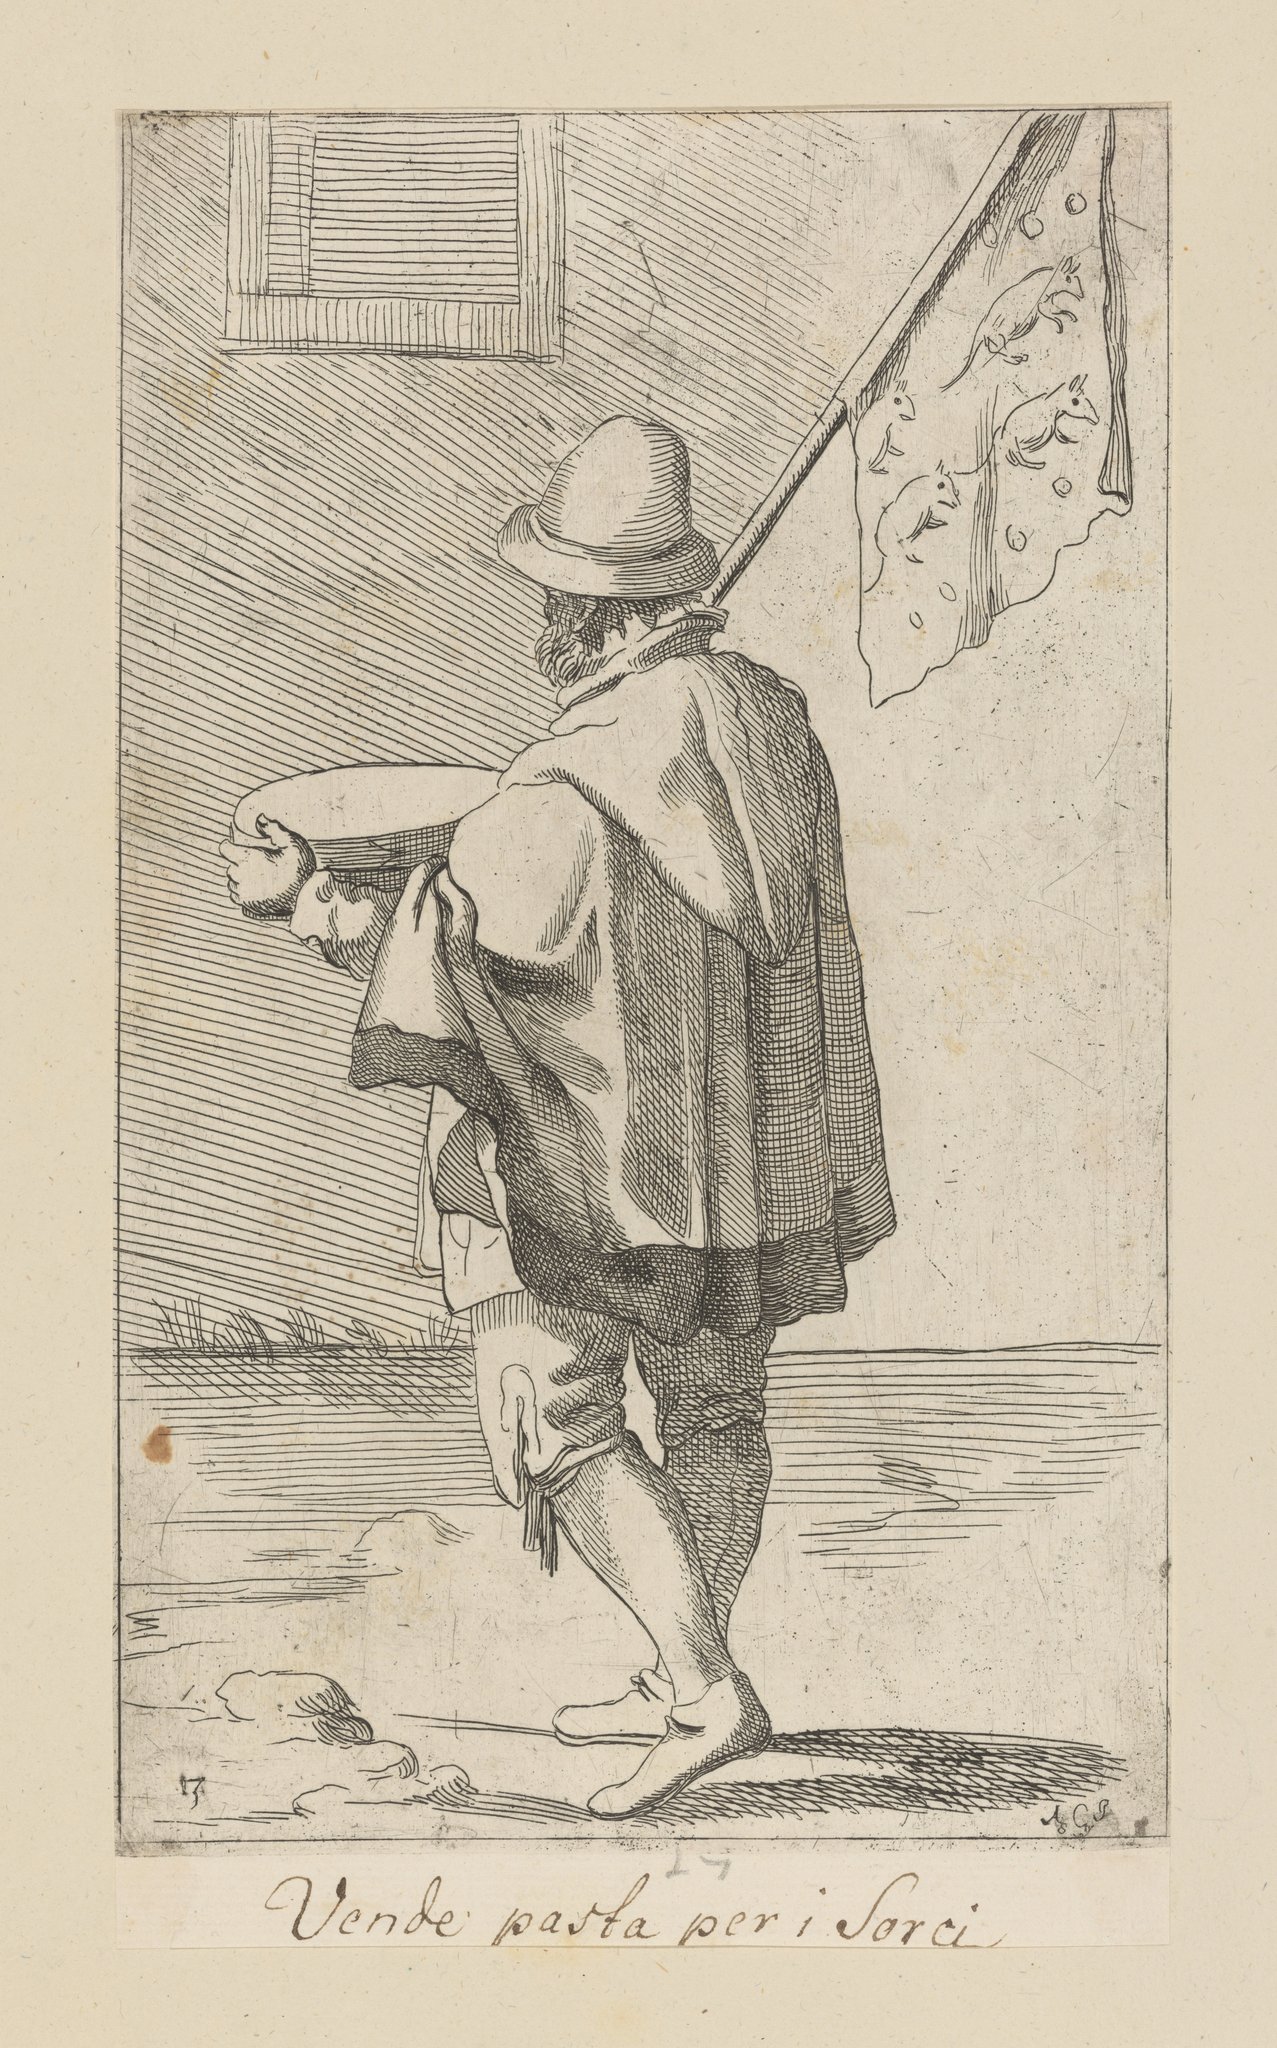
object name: print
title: Plate 13: Vendor of rat poison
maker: simon guillain ii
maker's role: artist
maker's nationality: french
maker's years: 1618-1718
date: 1646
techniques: etching